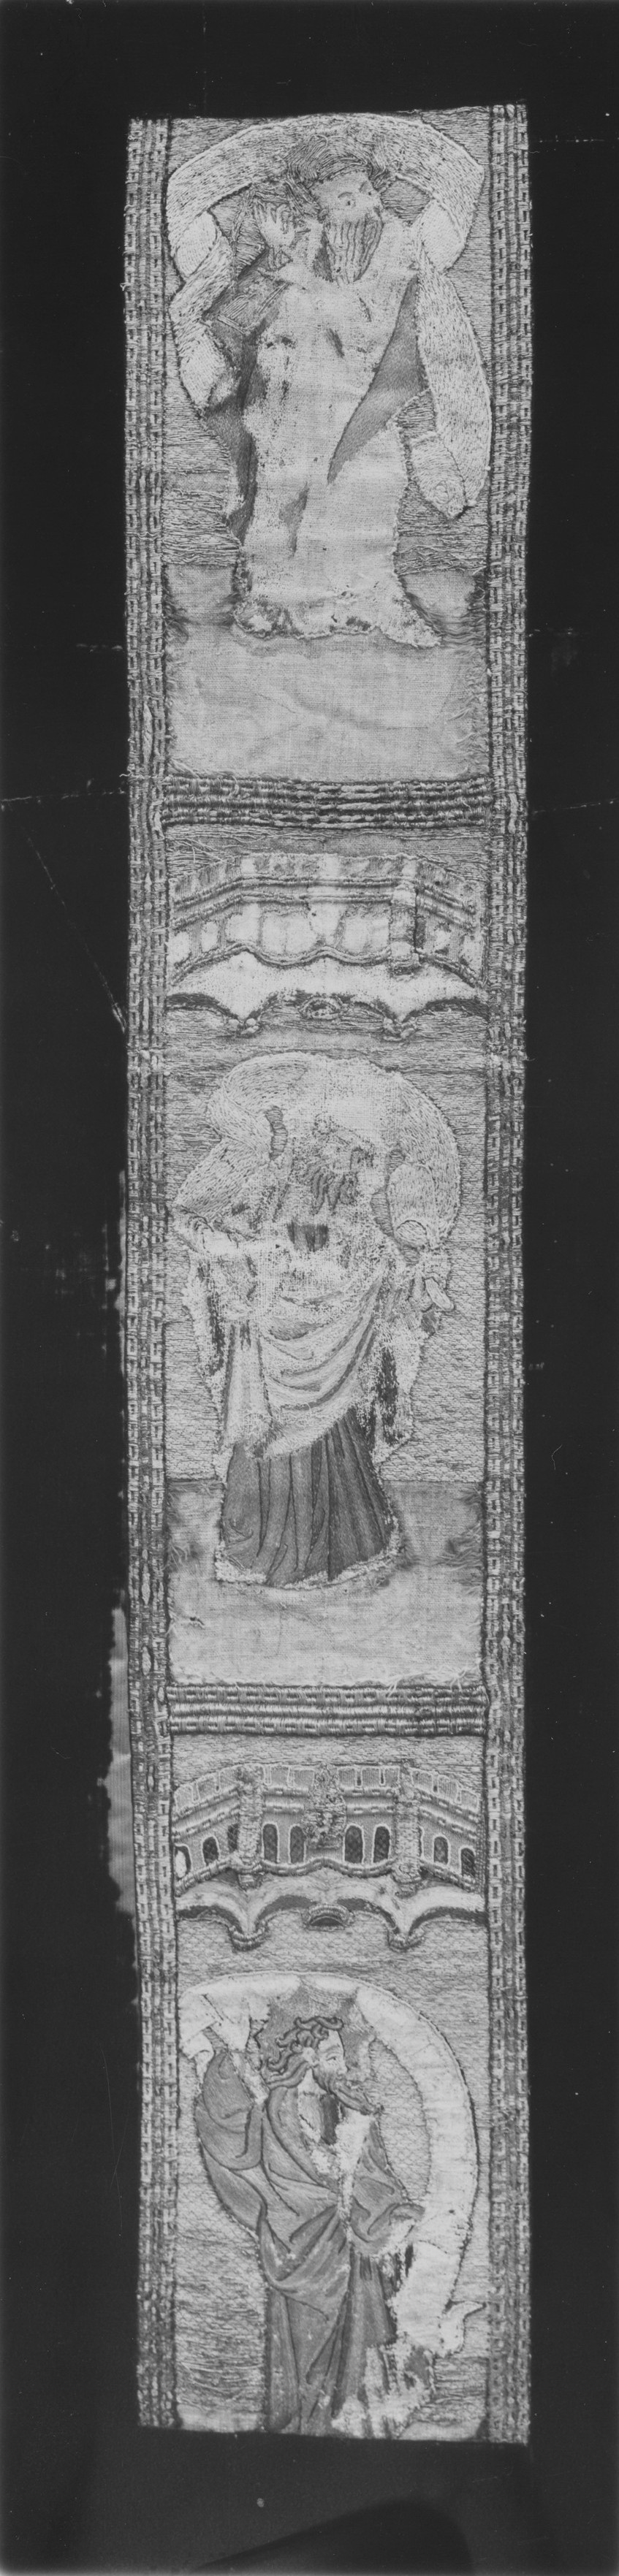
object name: orphrey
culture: spanish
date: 1401-1433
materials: silk, thread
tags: men